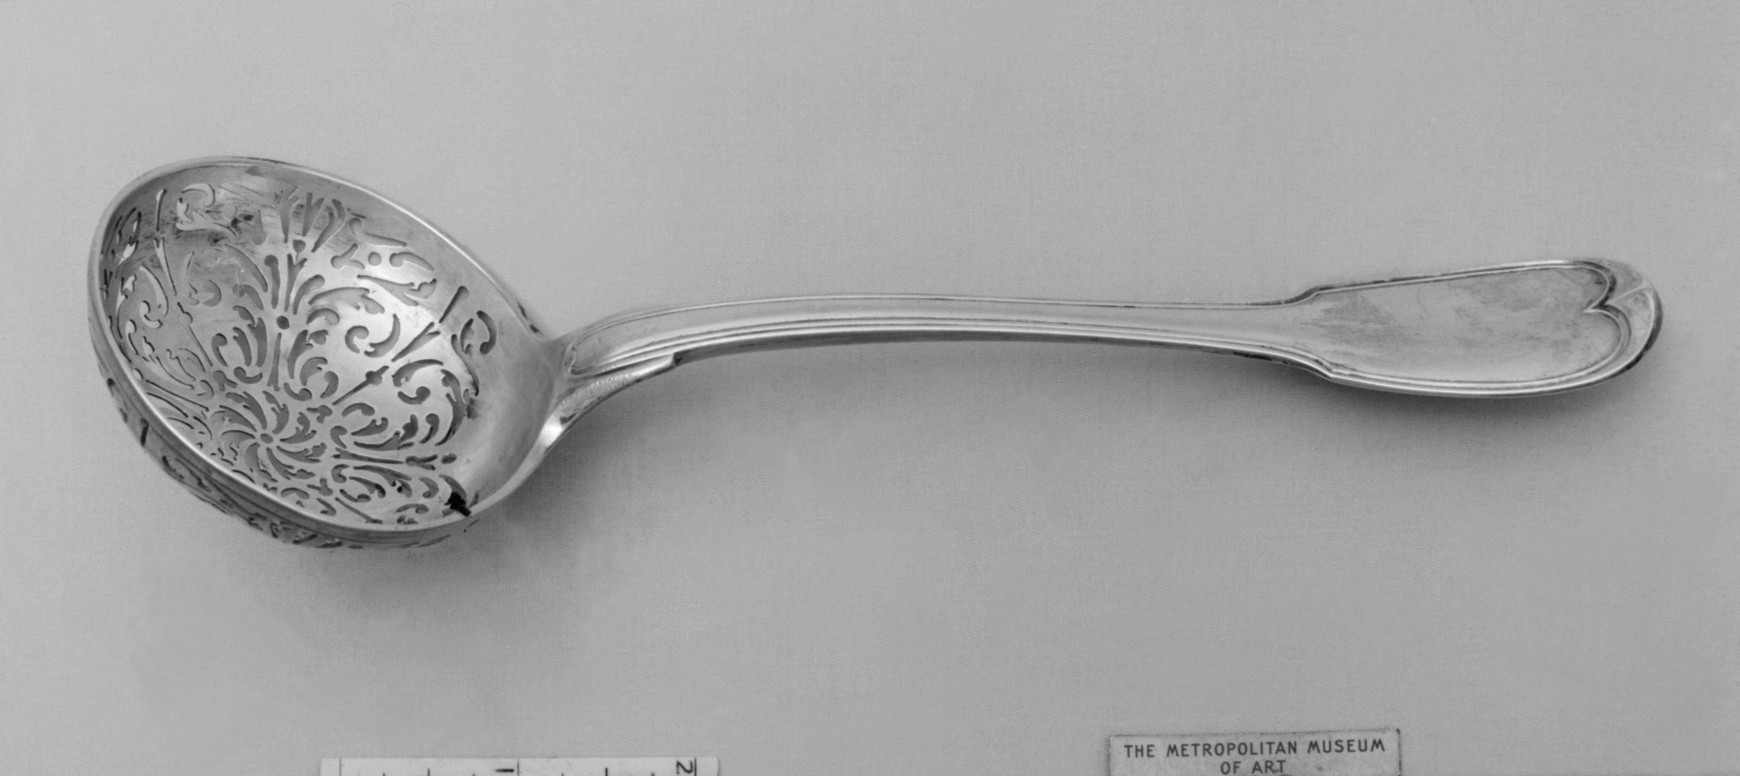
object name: sugar spoon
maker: pierre-nicolas sommé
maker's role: maker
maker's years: 1730-1836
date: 1786-1789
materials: silver